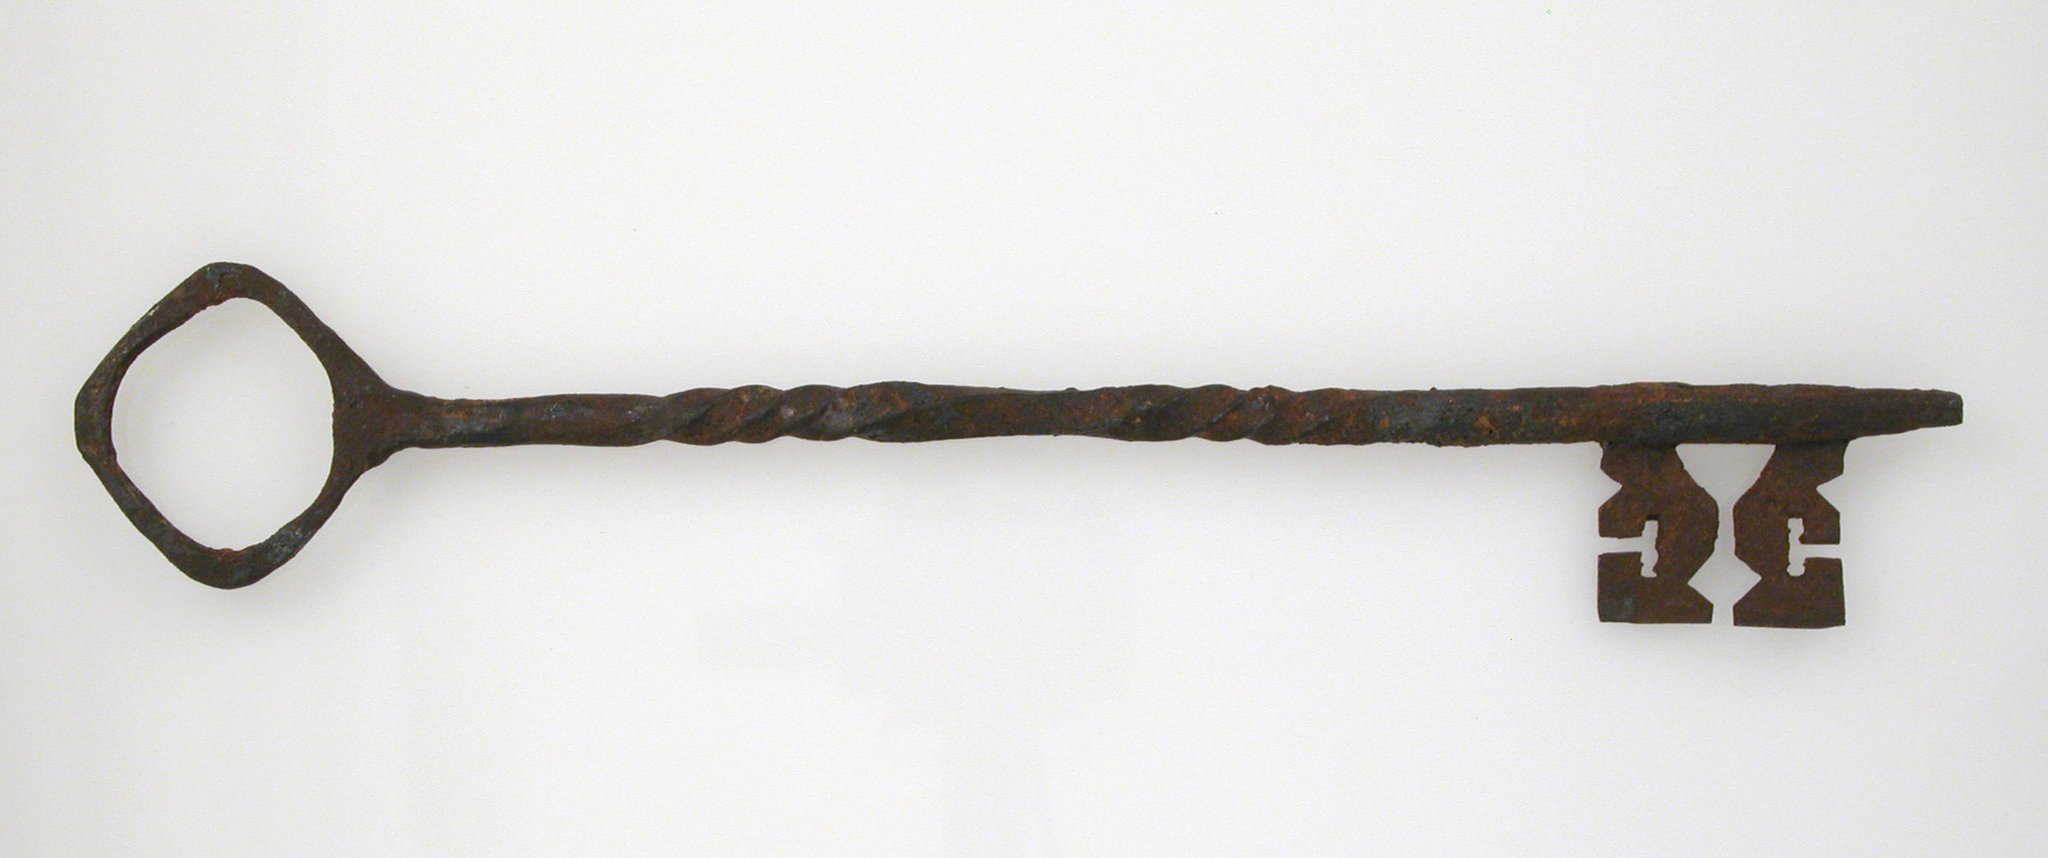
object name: key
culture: german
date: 1301-1350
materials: iron